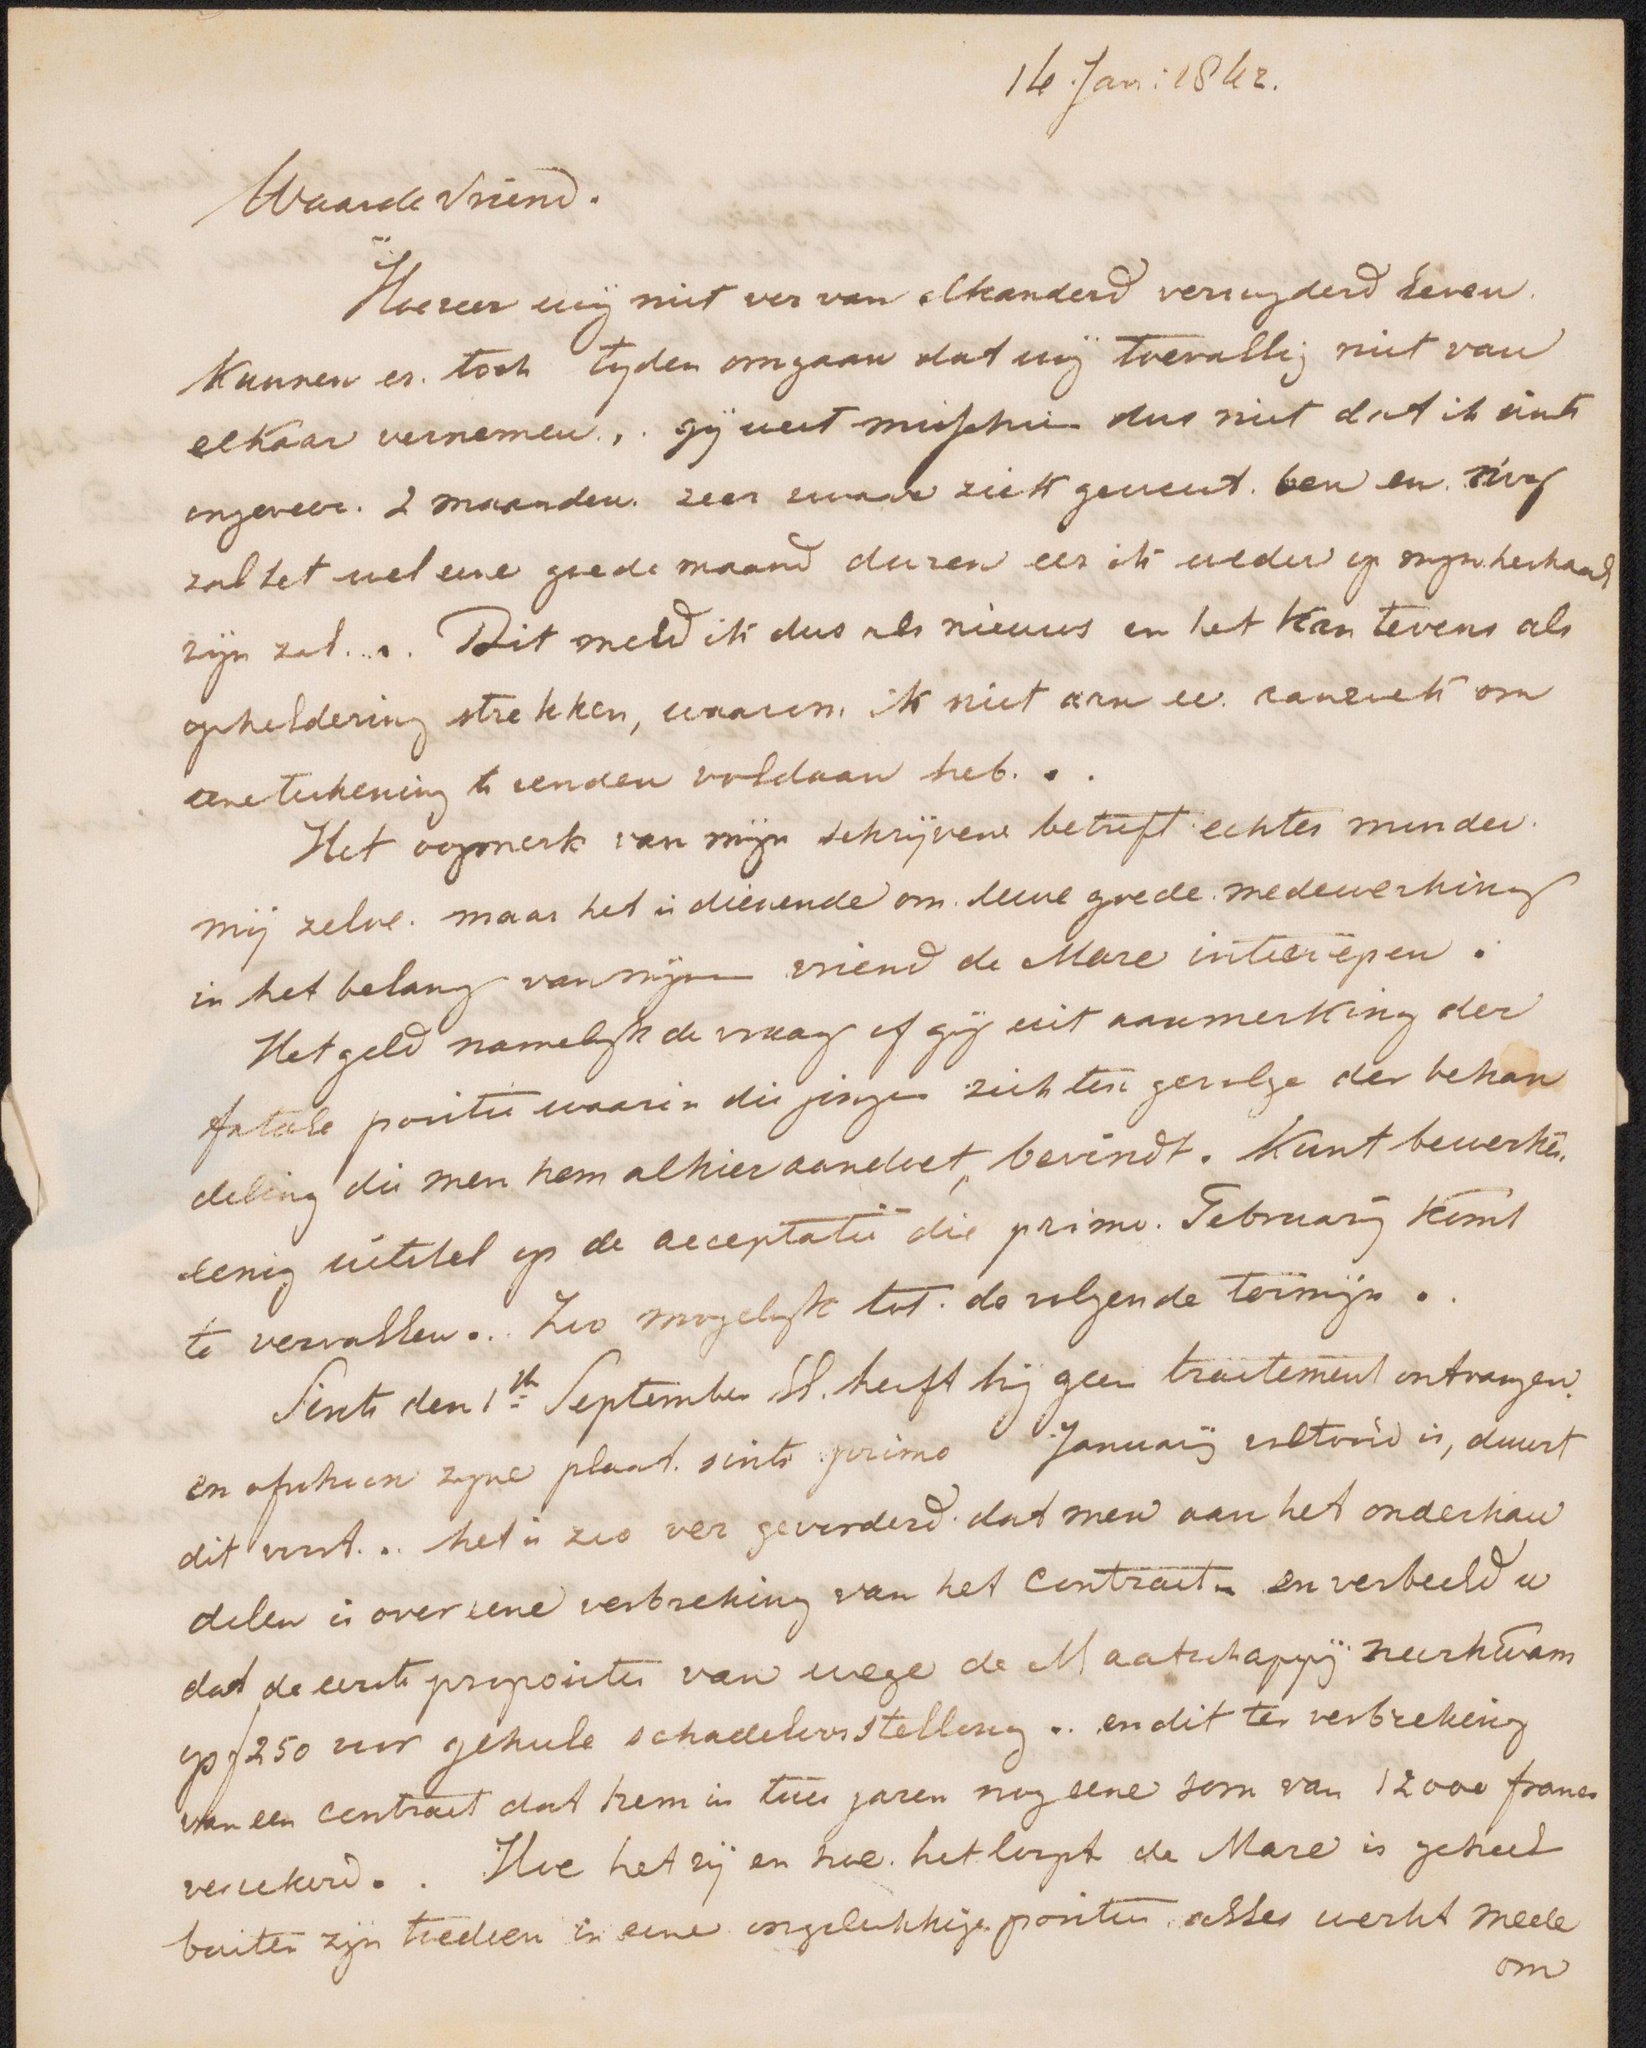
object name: letter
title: Brief aan Ary Johannes Lamme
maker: lodewijk anthony vintcent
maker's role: draughtsman, print maker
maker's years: 1812-1842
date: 1842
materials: ink, paper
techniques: pen, writing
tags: sculptor, ary scheffer, ary johannes lamme, amsterdam, johannes de mare, drawing, family life, diseases, money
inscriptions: collector's mark: Lugt 2228